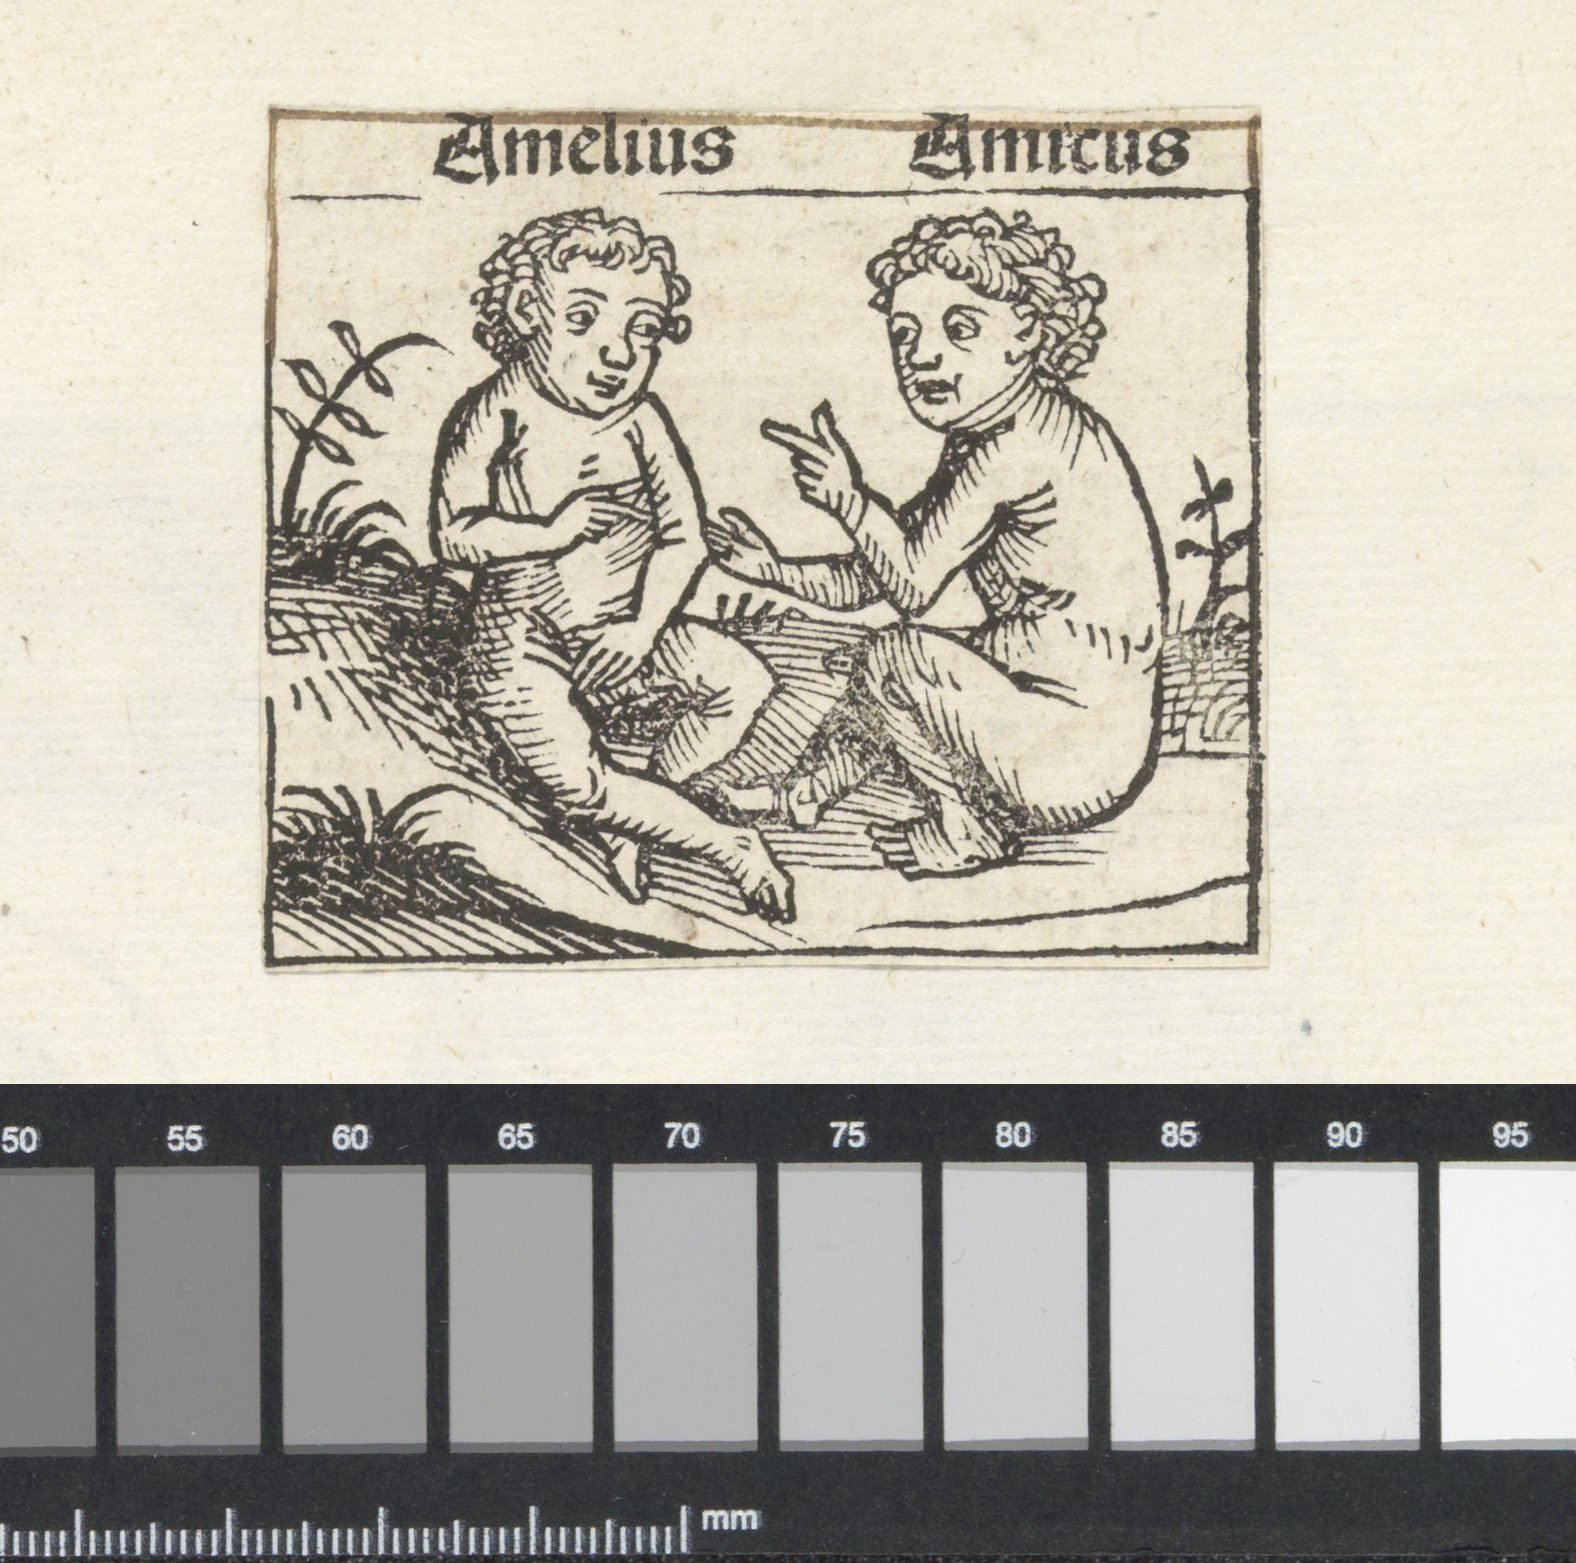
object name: print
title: Amelius en Amicus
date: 1493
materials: paper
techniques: letterpress printing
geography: nuremberg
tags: human life and its ages (young, adult, old, etc.)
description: De houtsnede wordt gebruikt als boekillustratie in de Liber Chronicarum (of Neurenbergkroniek) van Hartmann Schedel, verschenen in het Latijn en Duits in 1493. Zie de Latijnse uitgave, folio 164v.